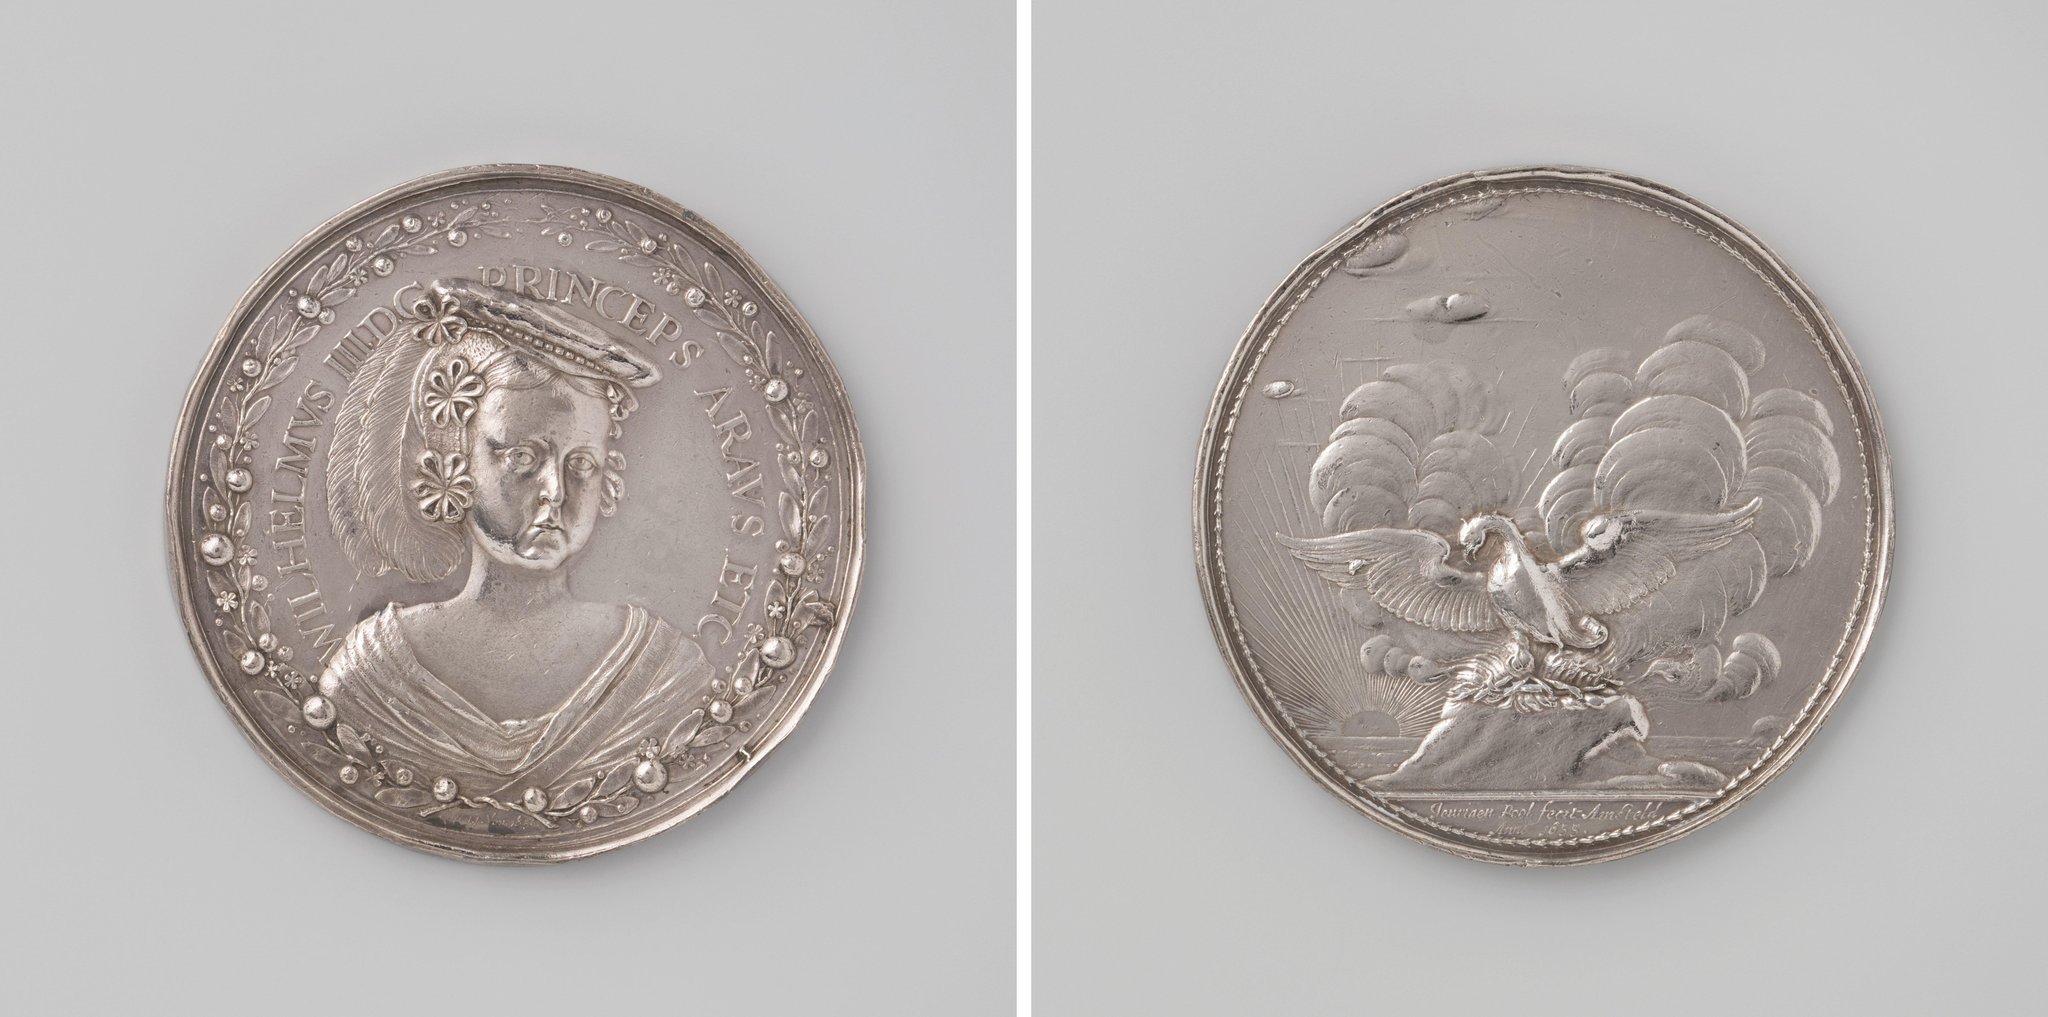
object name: history medal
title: Willem III, prins van Oranje-Nassau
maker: juriaen pool (i)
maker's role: medailleur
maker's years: 1618-1669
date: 1655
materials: silver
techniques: striking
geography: amsterdam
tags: william iii (prince of orange and king of england, scotland, and ireland)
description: Zilveren penning. Voorzijde: borststuk jongen met vederbaret binnen omschrift en krans van oranjetakken. Keerzijde: Fenix op zijn nest, op achtergrond zonsopgang